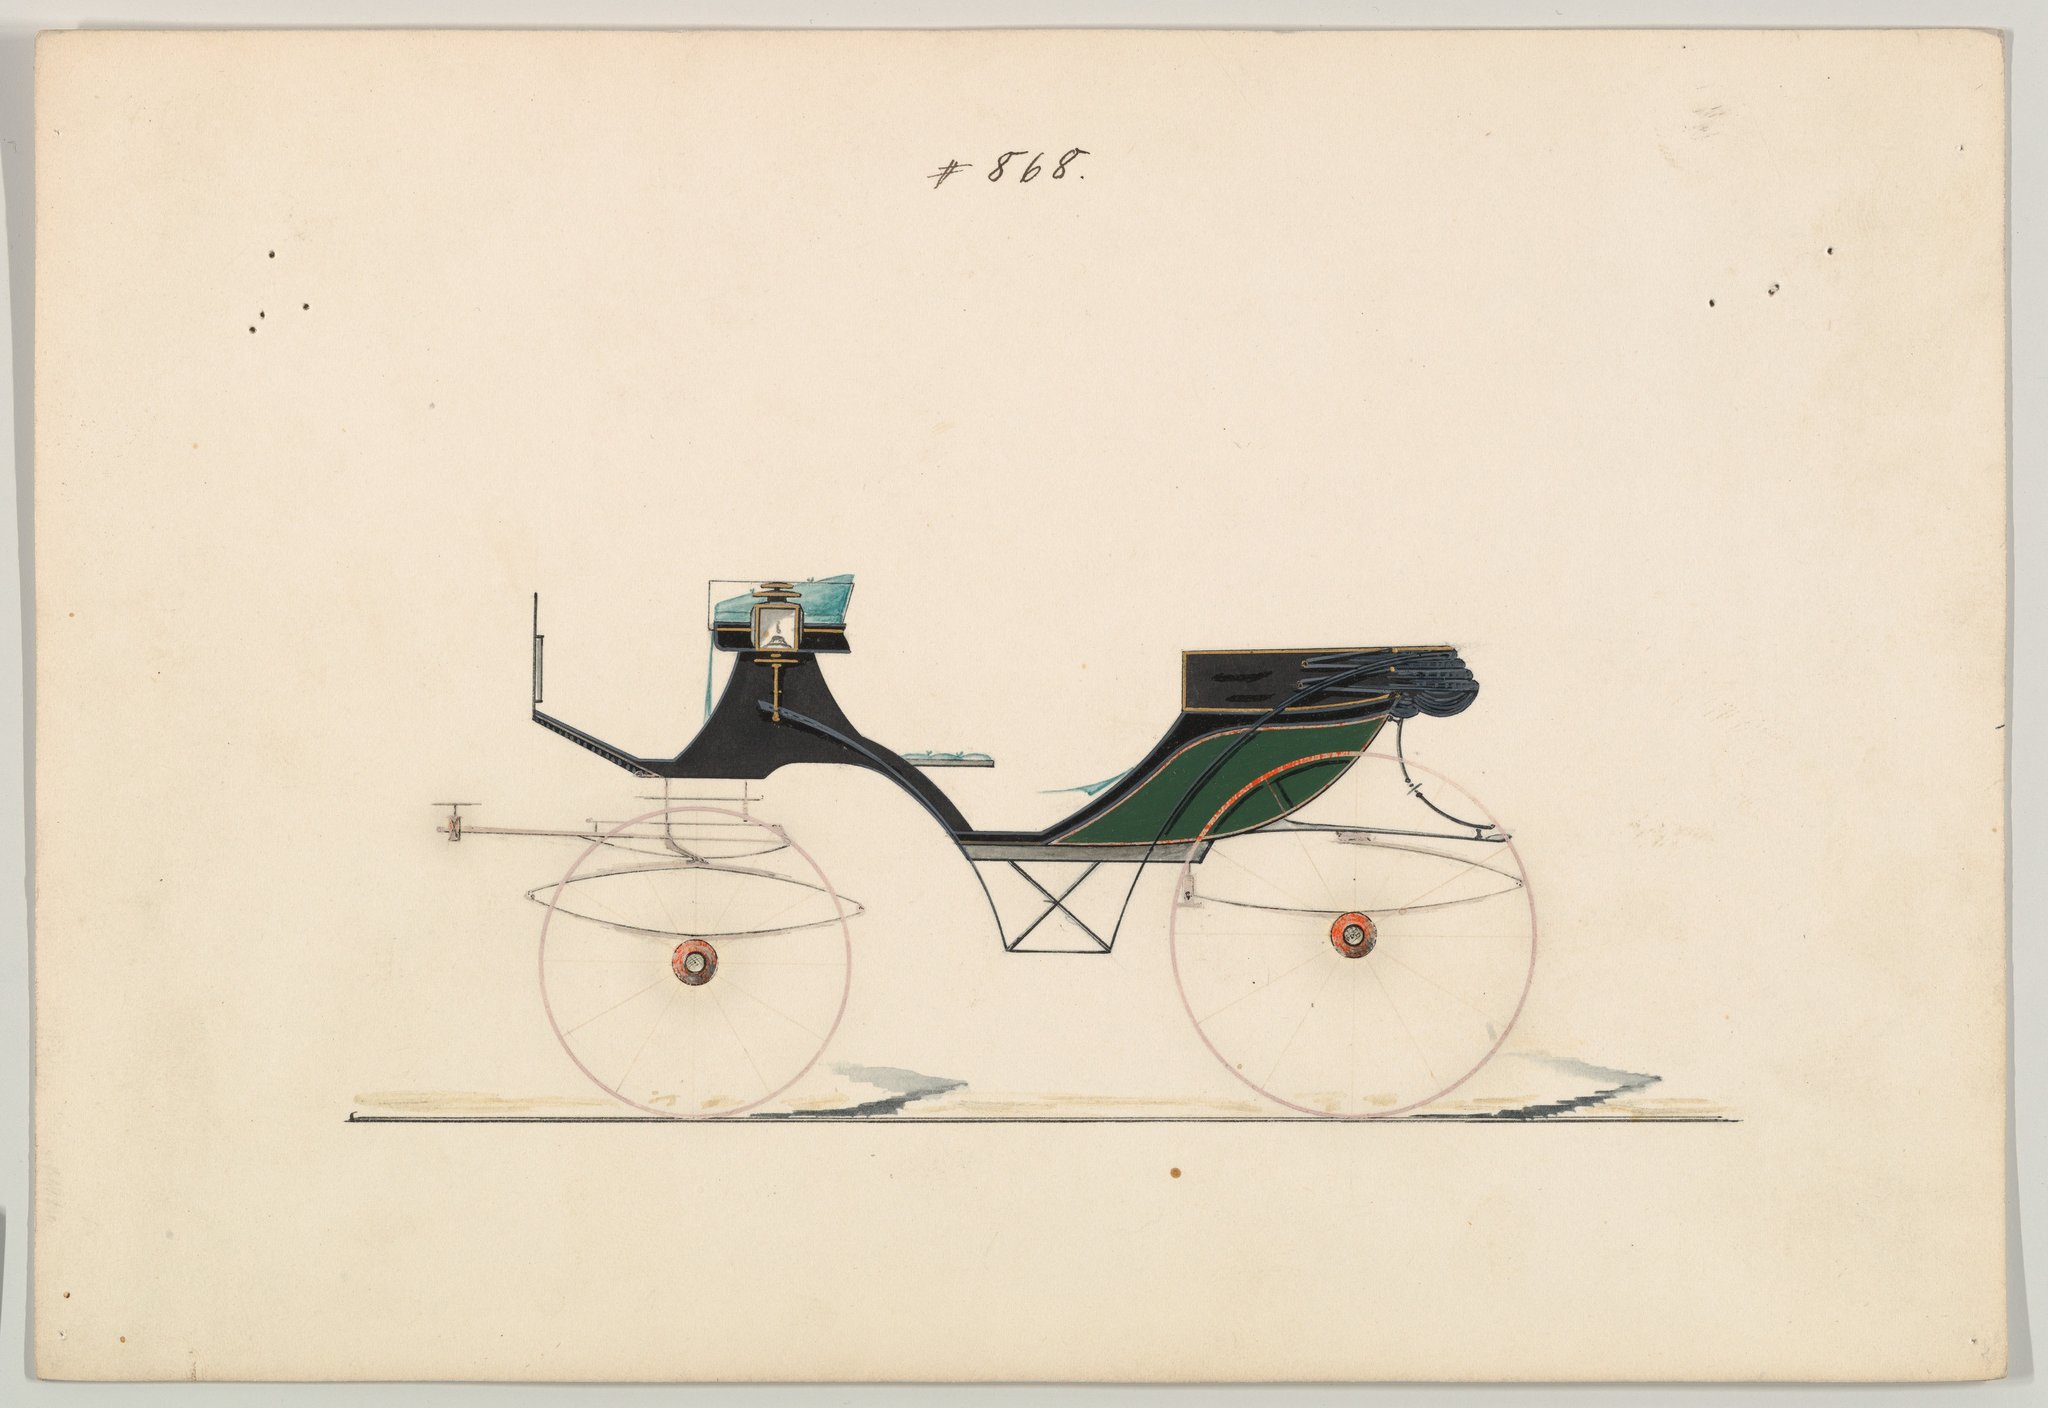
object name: drawing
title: Cabriolet #868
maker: brewster & co.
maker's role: manufacturer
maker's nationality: american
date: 1870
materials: gouache, gum arabic, ink, watercolor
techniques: pen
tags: carriages